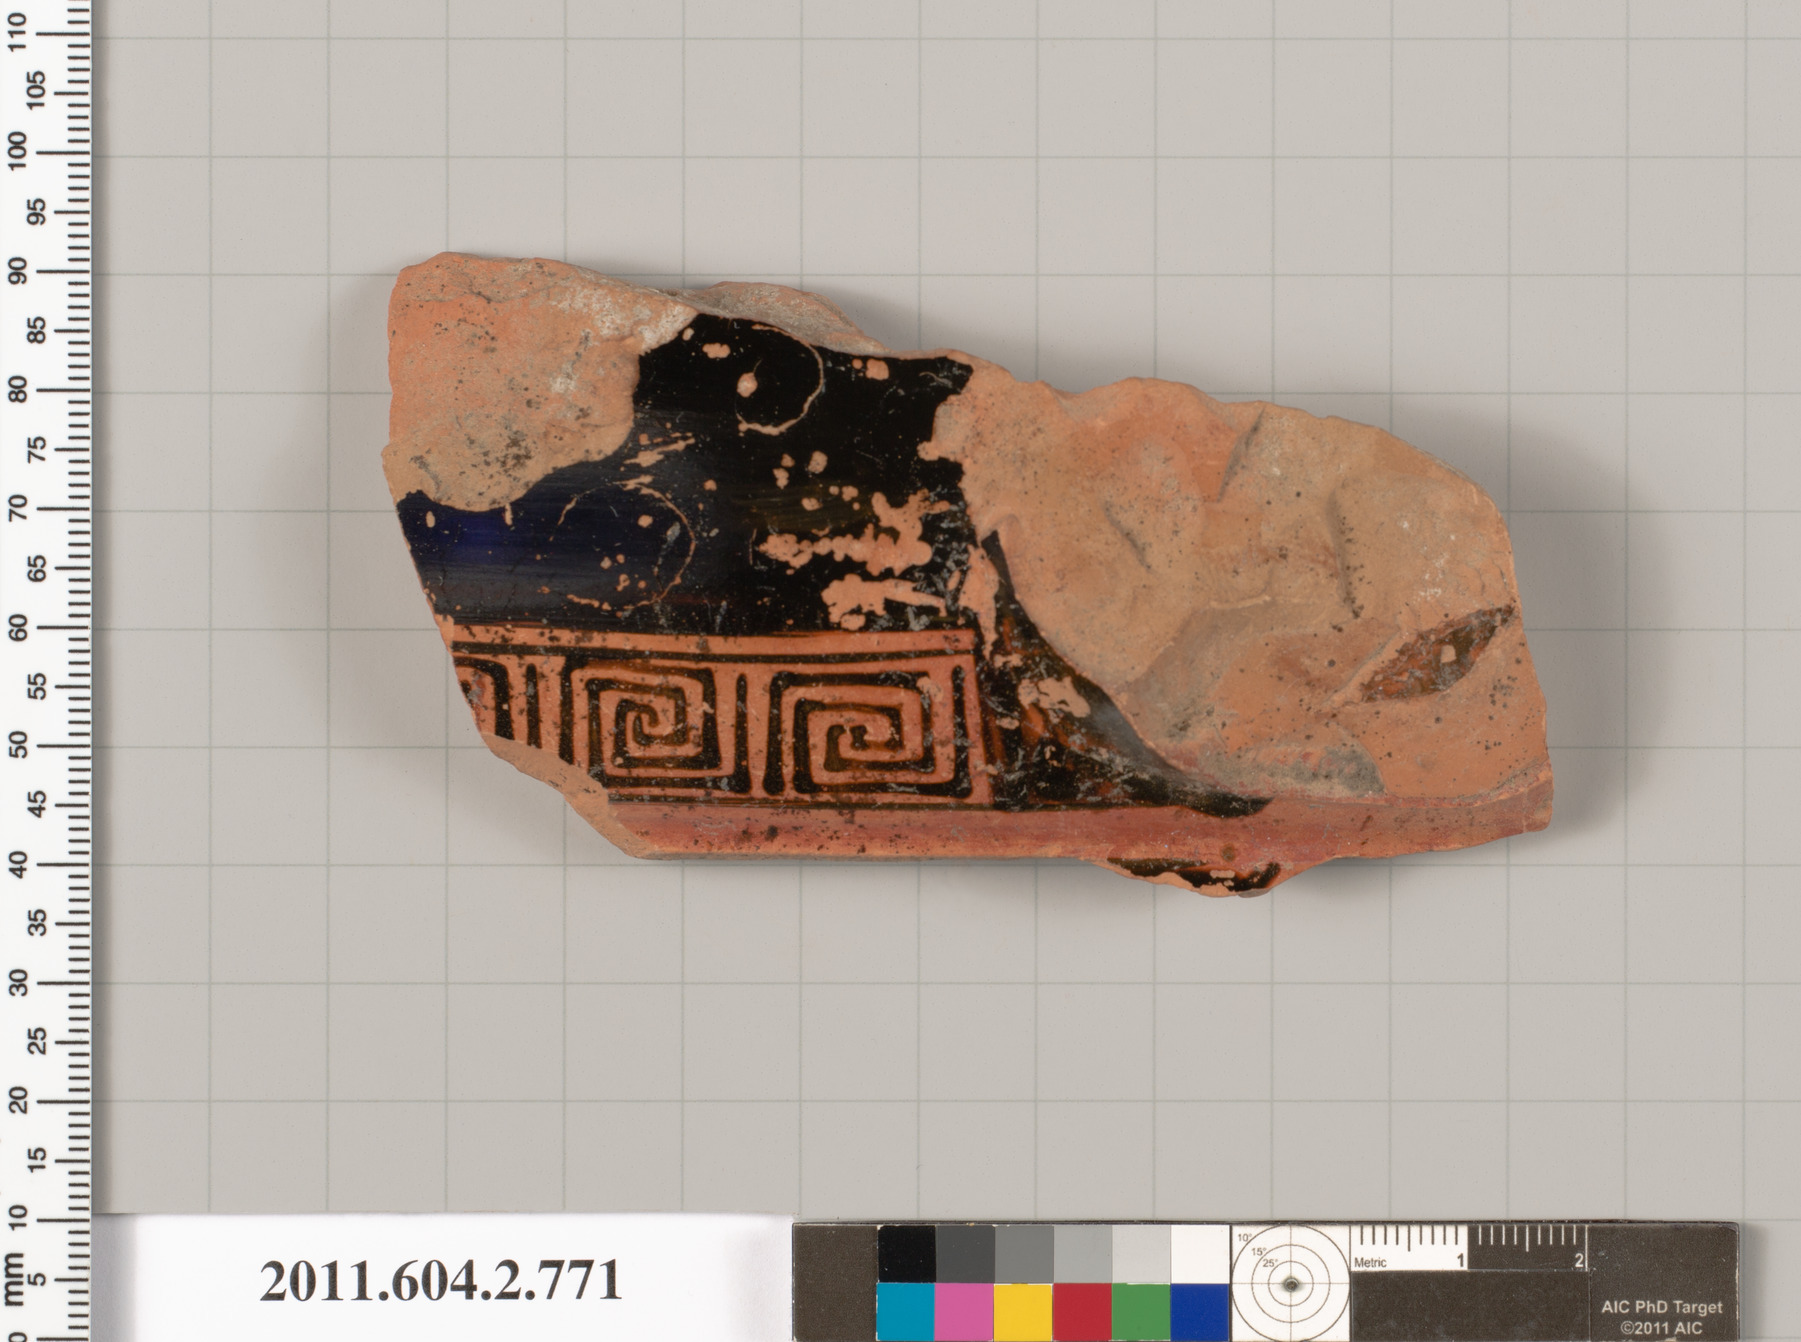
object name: calyx krater fragment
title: Terracotta fragment of a calyx-krater (bowl for mixing wine and water)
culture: greek, attic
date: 470-460 BCE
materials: terracotta